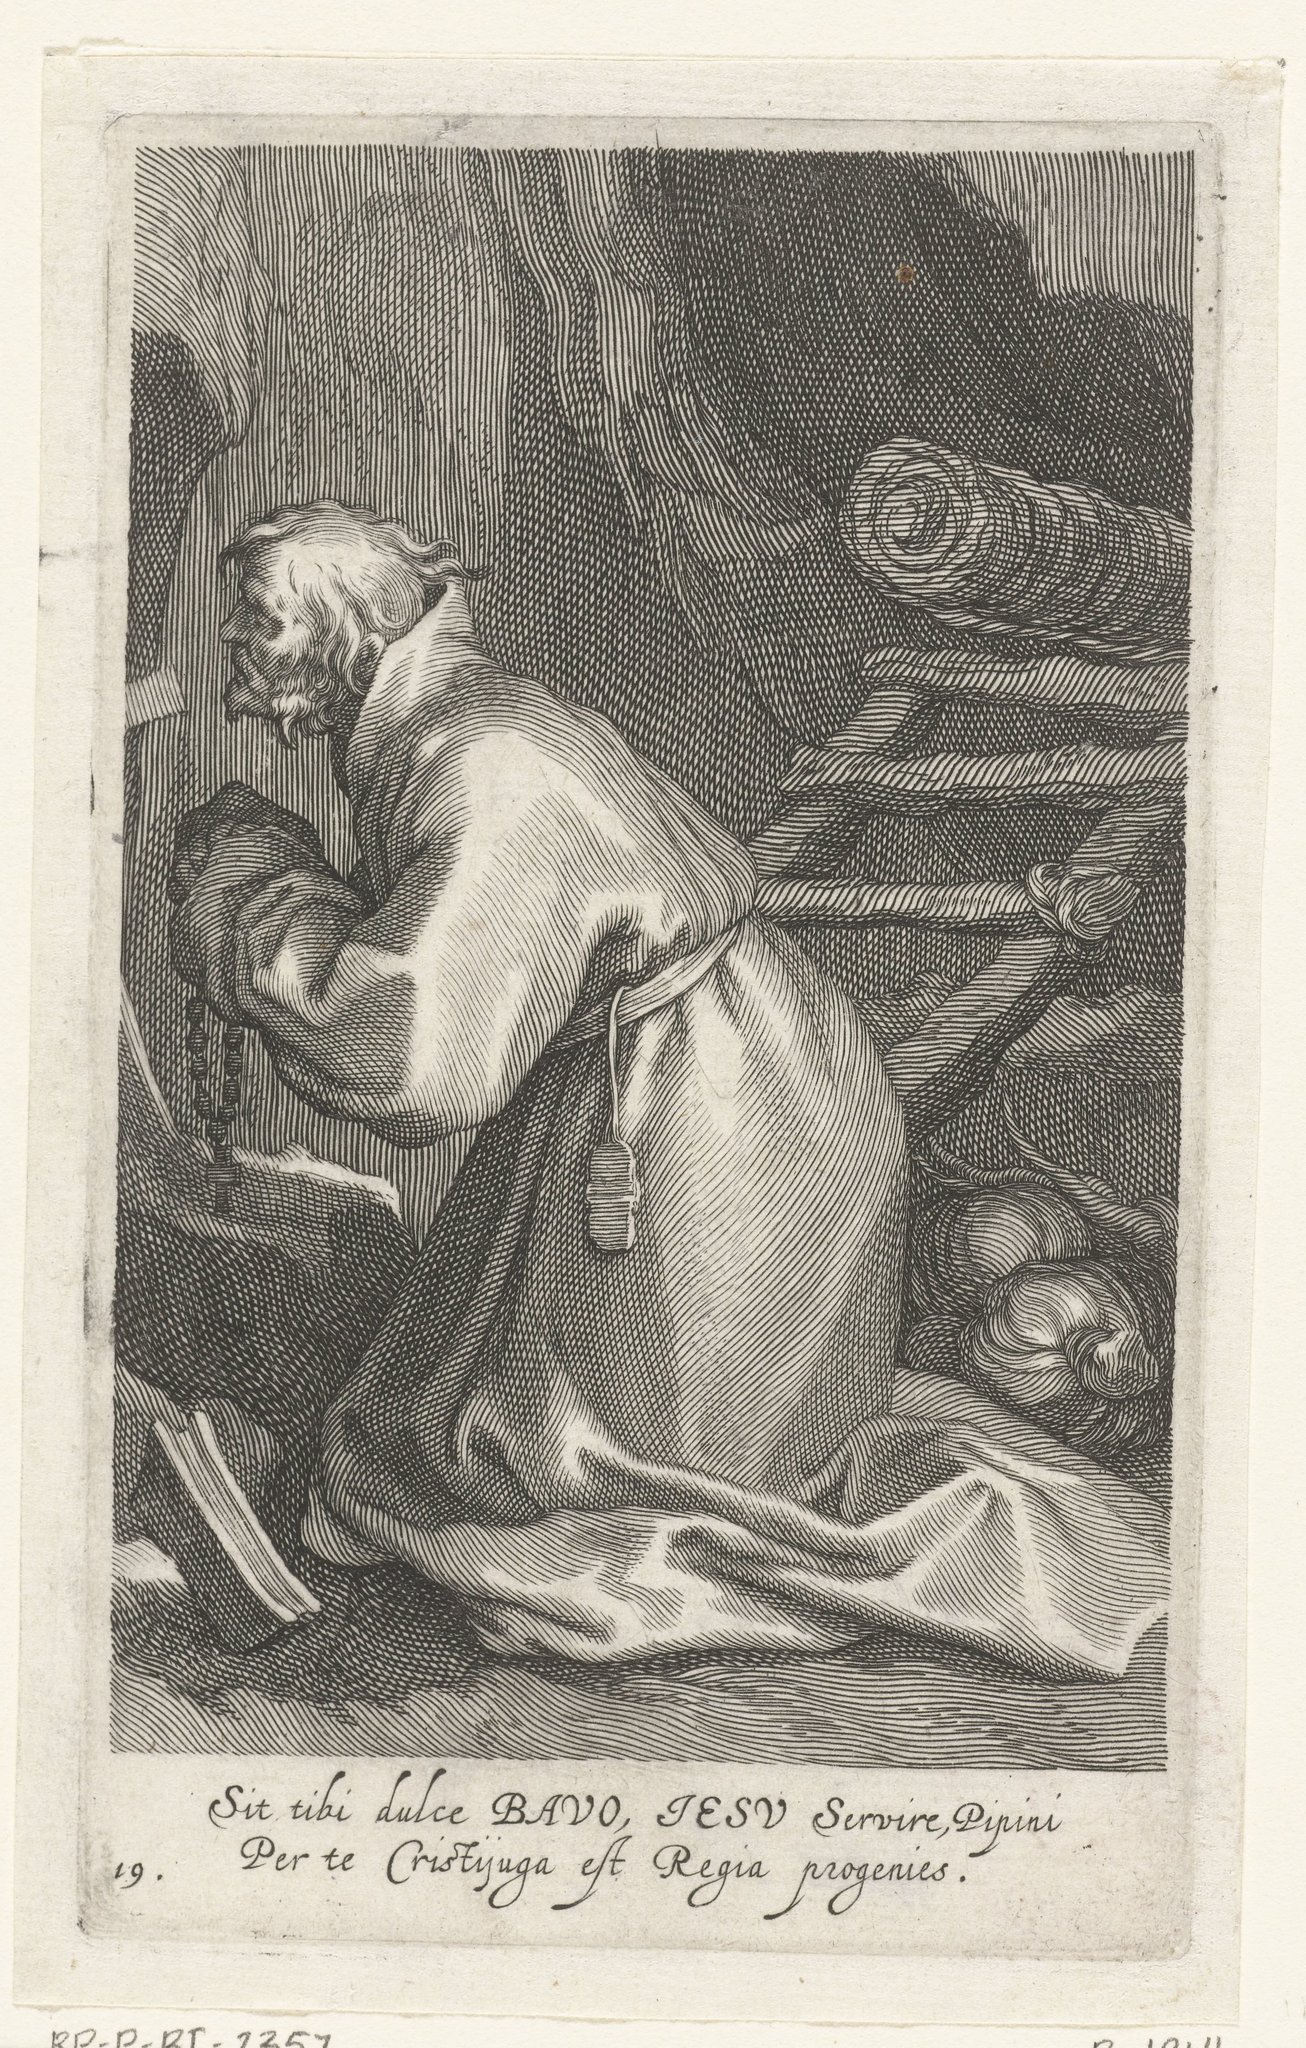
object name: book illustration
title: Ad sacrum speculum (...) patribus dat ales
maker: boëtius adamsz. bolswert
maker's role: print maker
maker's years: 1580-1633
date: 1590-1612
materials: paper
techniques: engraving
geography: low countries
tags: anchorite, hermit, the hermit bavo of ghent; possible attributes: falcon, hollow tree, purse, stone, sword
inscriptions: collector's mark: Lugt 240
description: Prent uit: Ad sacrum speculum recurris? ... patribus dat ales, geen plaats, Boëtius Adamsz. Bolswert, 1612. Tweede ongebonden uitgave met in totaal vijftig prenten. Prent uit serie van drieentwintig mannelijke kluizenaars. In 1619 verscheen een gebonden editie maar op basis van de gewijzigde opschriften en samenstelling wordt aangenomen dat deze prenten ook in 1612 of iets daarvoor gedrukt werden. Roethlisberger beschouwt de uitgave van 1619 als de eerste staat en de ongebonden editie van 1612 als de tweede staat (Roethlisberger 1993, p. 171, 172).